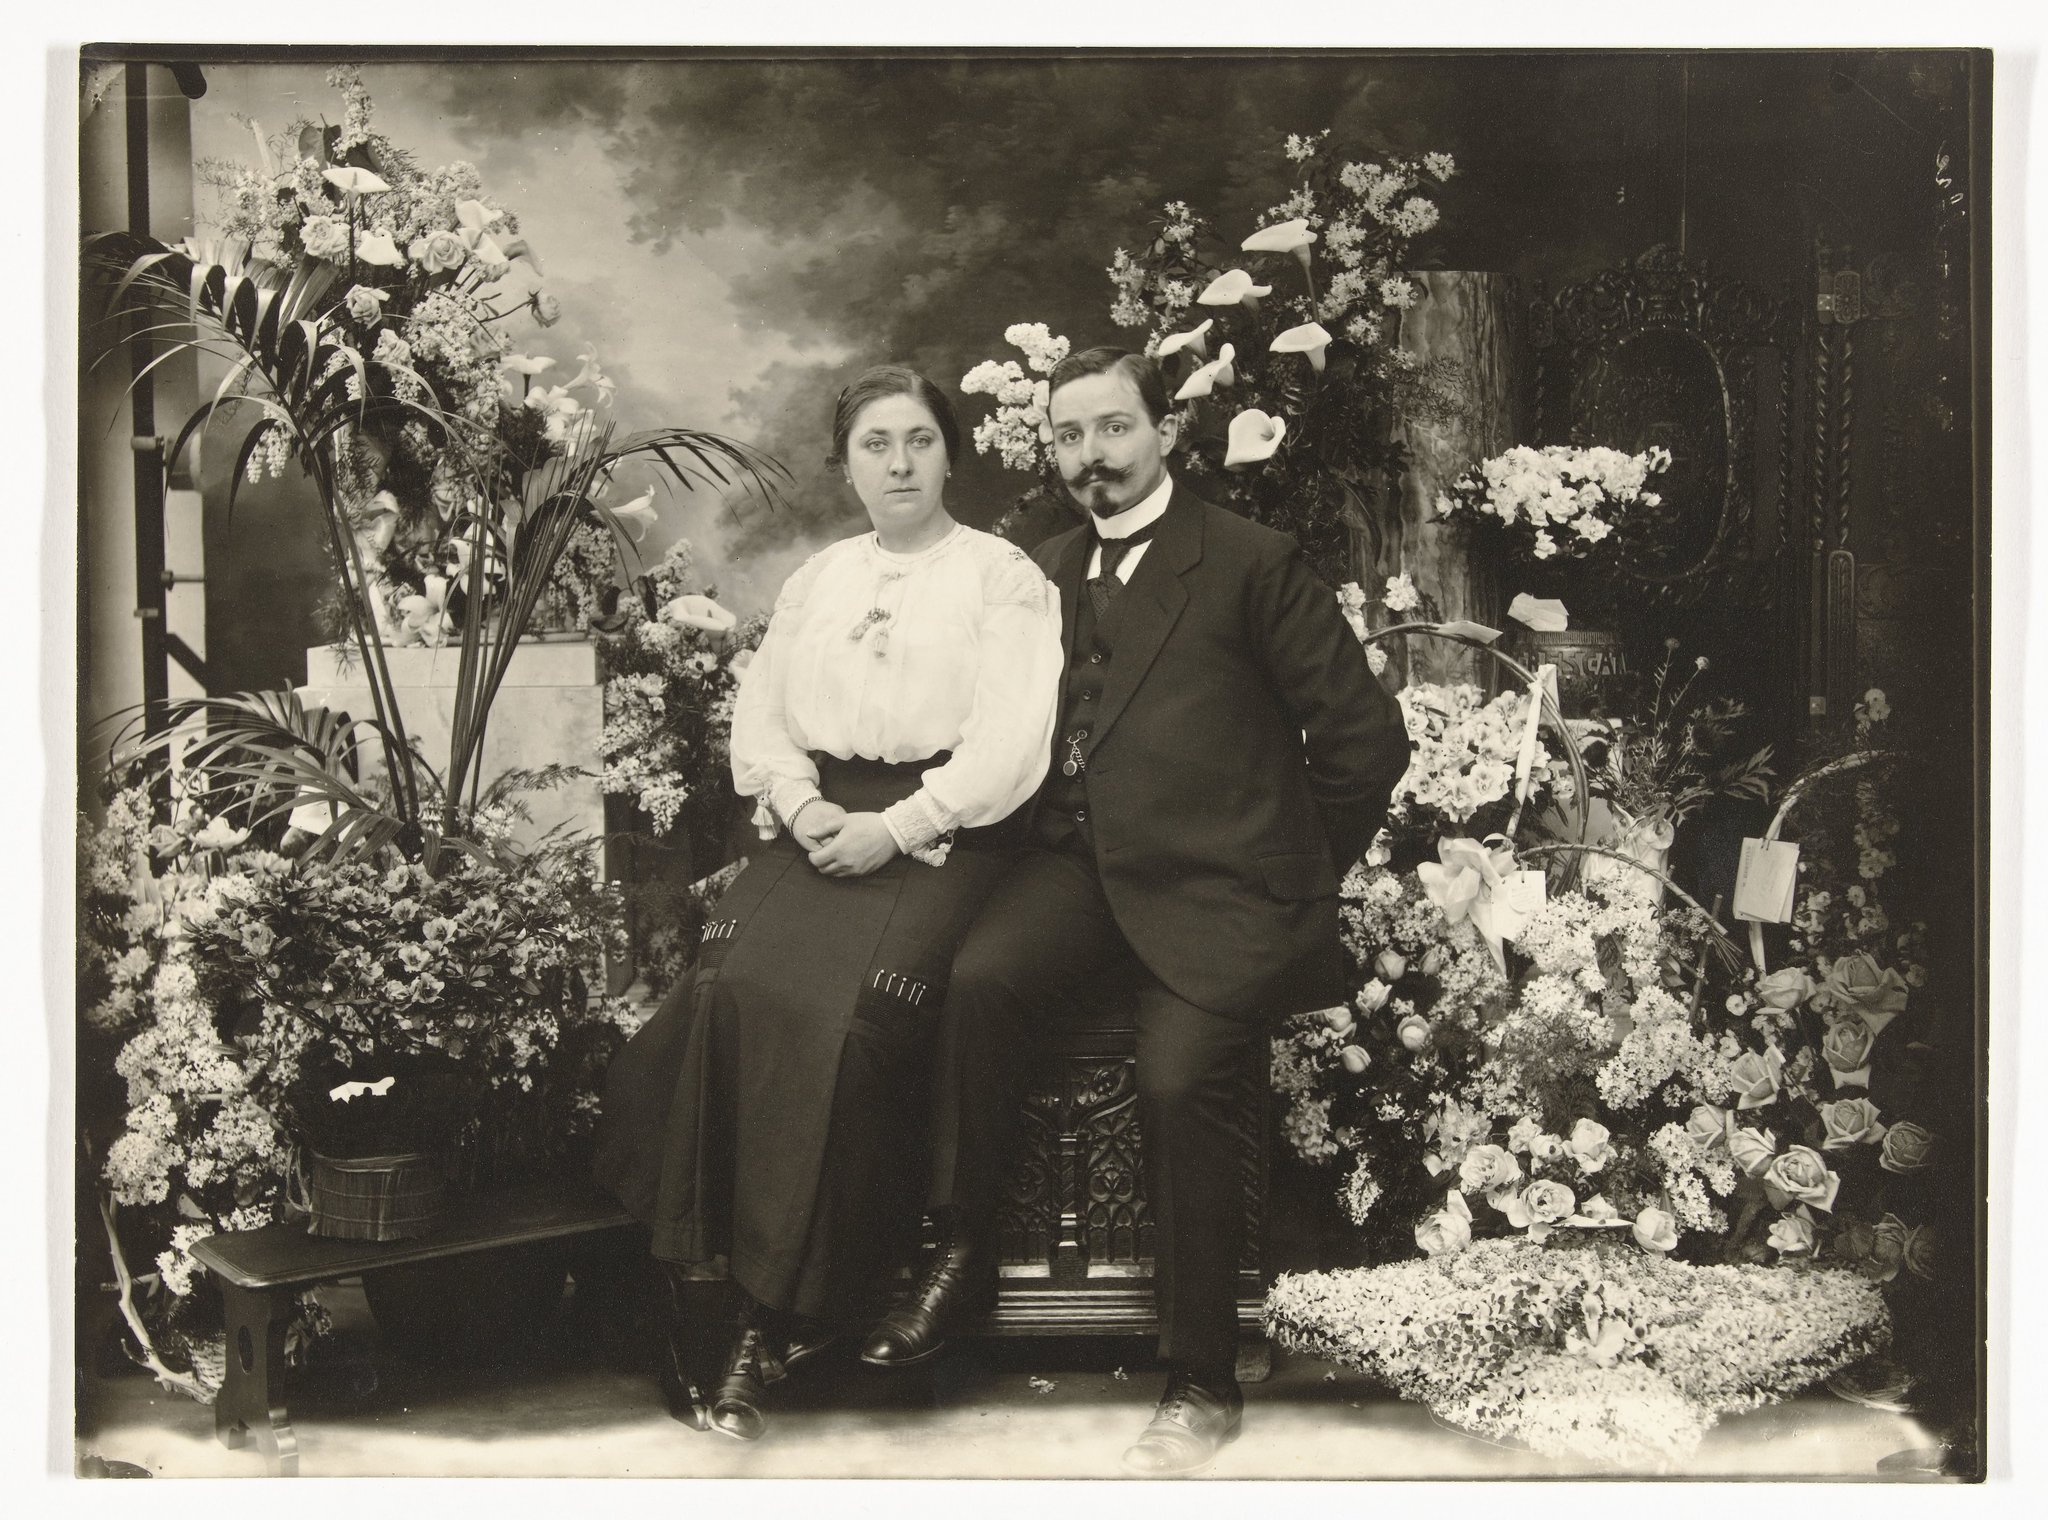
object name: photograph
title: Portret van Jacob Merkelbach en echtgenote omringd door bloemen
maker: jacob merkelbach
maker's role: fotograaf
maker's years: 1877-1942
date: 1905-1913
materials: photographic support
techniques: gelatin silver print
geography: amsterdam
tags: marriage, married couple, 'matrimonium', historical persons (portraits and scenes from the life)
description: Portret van Jacob Merkelbach en echtgenote omringd door bloemen bij opening atelier boven Hirsch op het Leidseplein, mei 1913